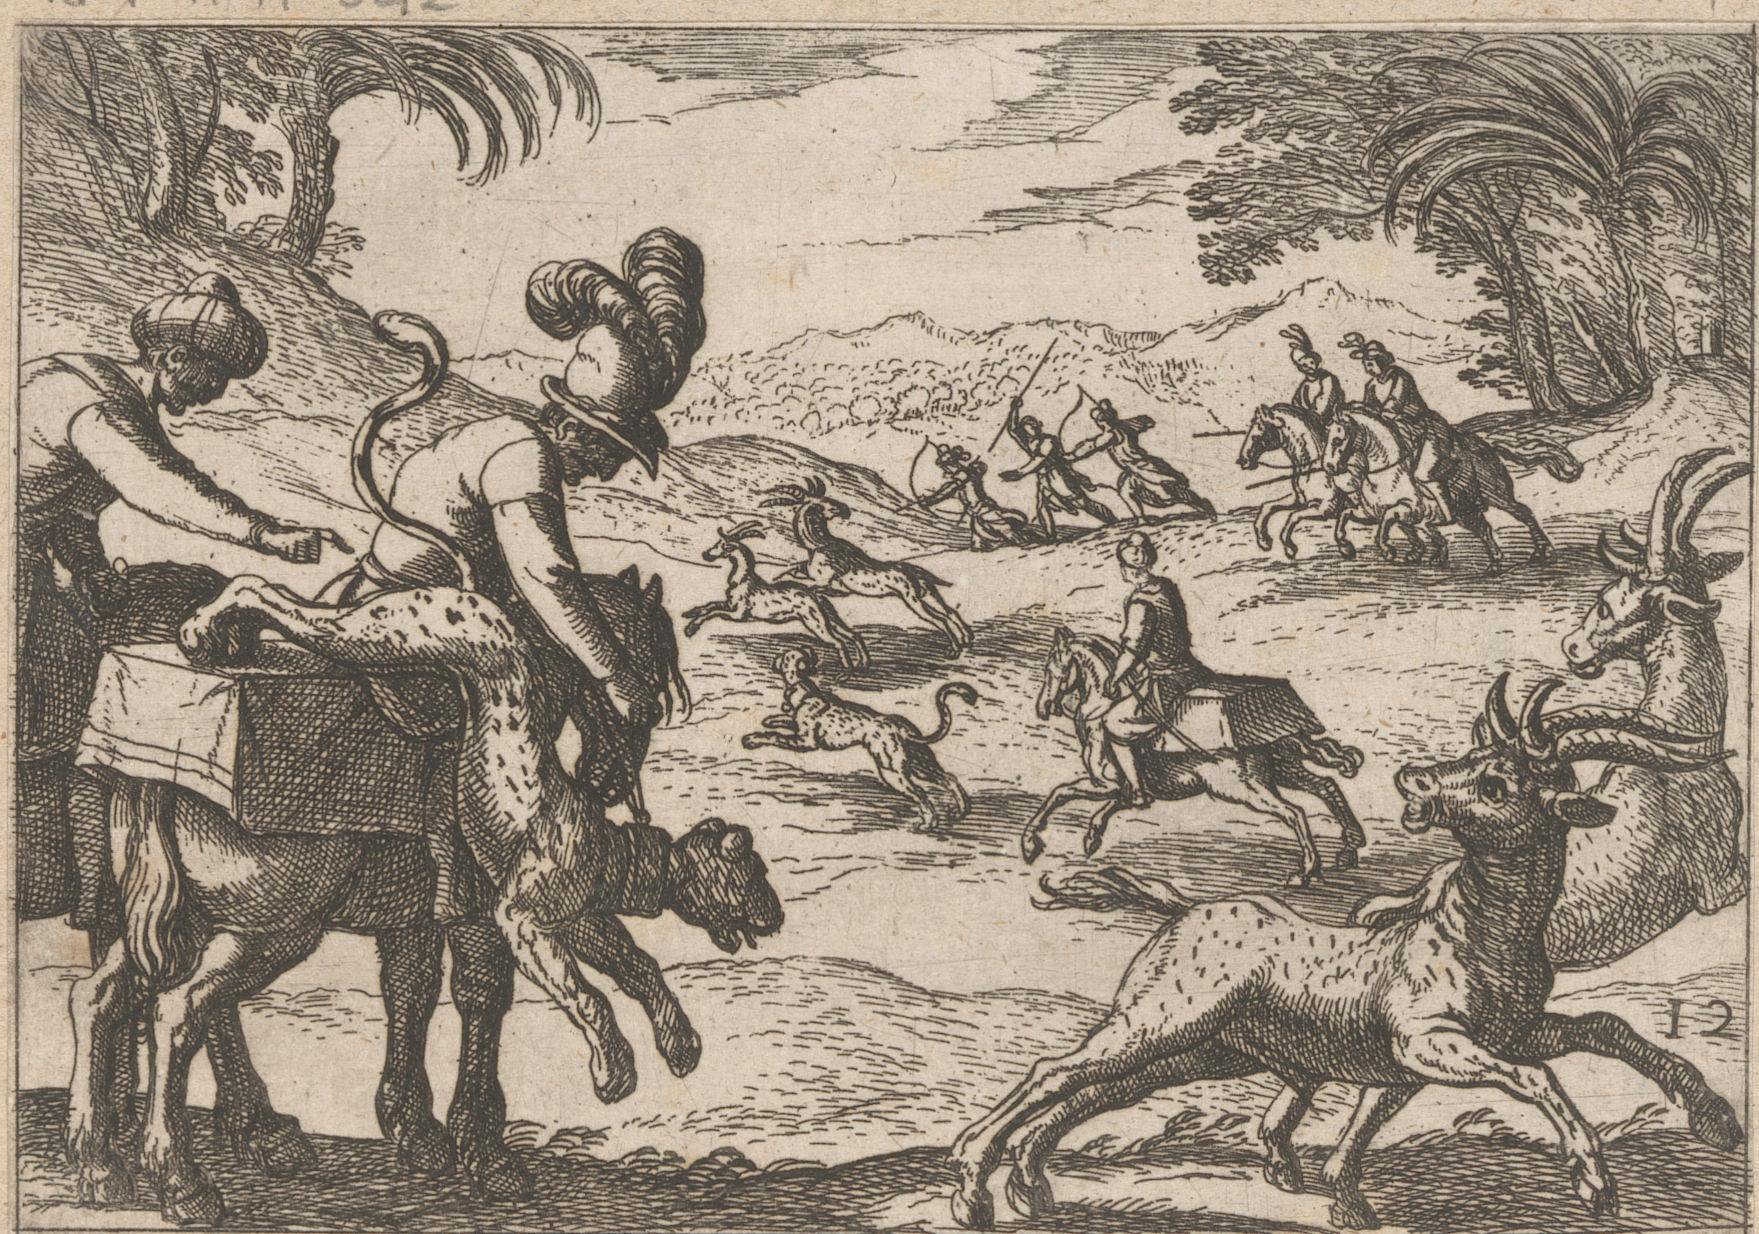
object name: print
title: Jacht op antilopen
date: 1598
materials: paper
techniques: etching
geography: italy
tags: beasts of prey, predatory animals: leopard, hunter, hunters hunting (n.b.: in 1988-1990 this notation denoted the concept of 43c11421 'hunters resting during the hunt'), hoofed animals: antelope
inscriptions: collector's mark: ‘Hinloopen’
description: Deze prent maakt deel uit van een reeks van vijftien prenten met jachtscènes (+ opdracht).